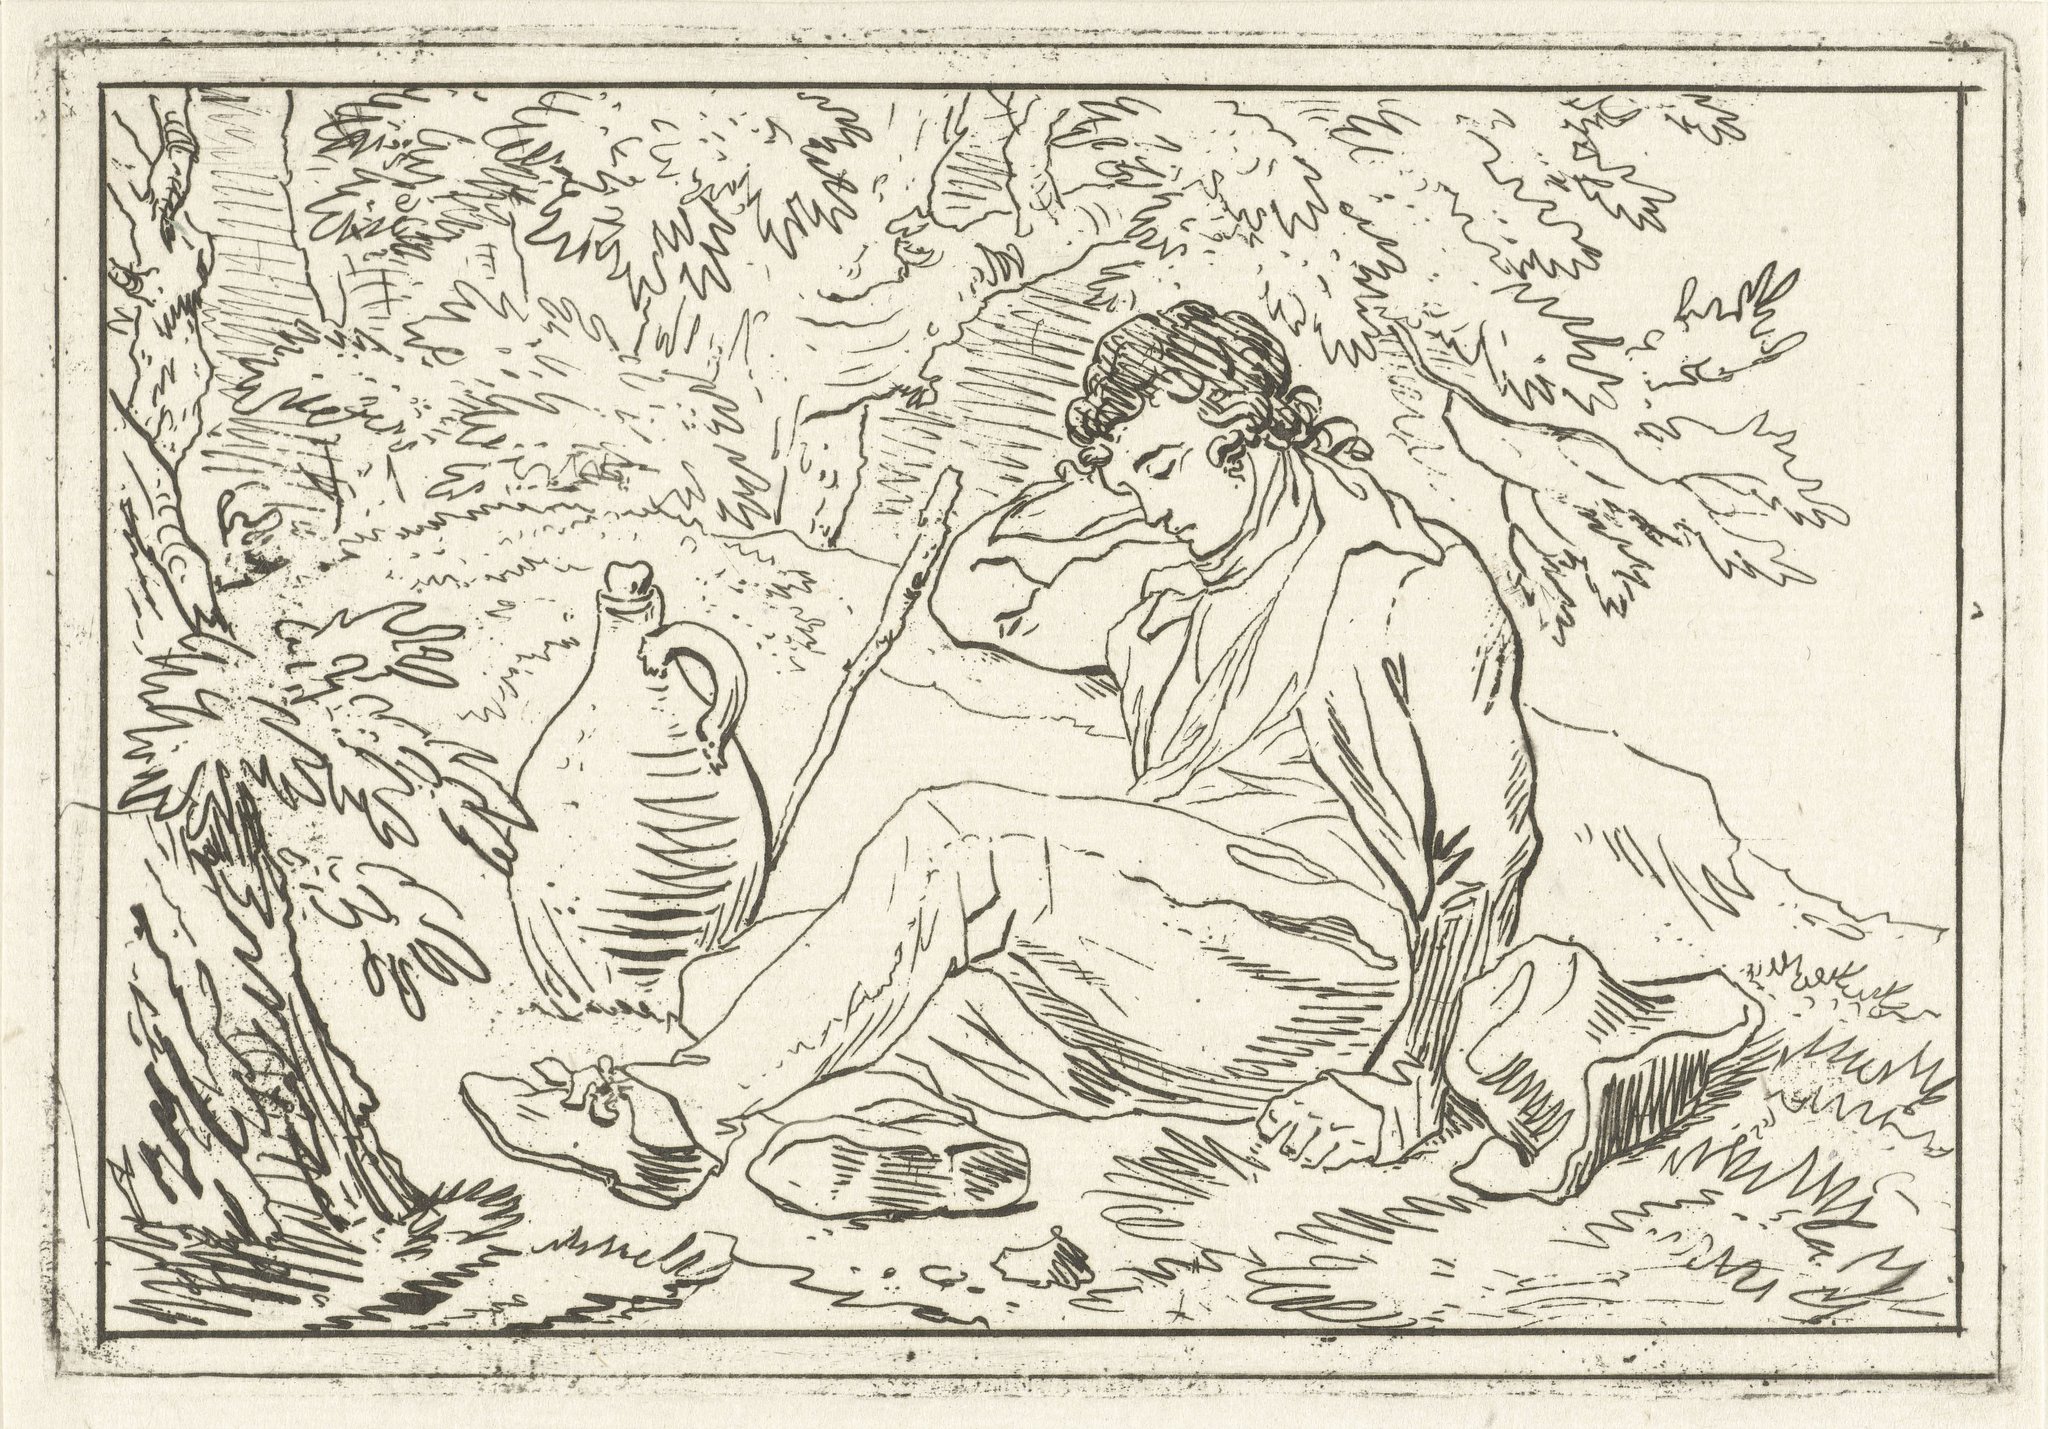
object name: print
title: Slapende man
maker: hermanus fock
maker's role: conservator, draughtsman, painter, print maker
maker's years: 1766-1822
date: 1781-1822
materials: paper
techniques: etching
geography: amsterdam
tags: sleeping; unconsciousness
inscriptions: collector's mark: Lugt 2228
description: Een man slaapt in het gras tussen zijn hoed en een grote kruik. Op de achtergrond bomen.